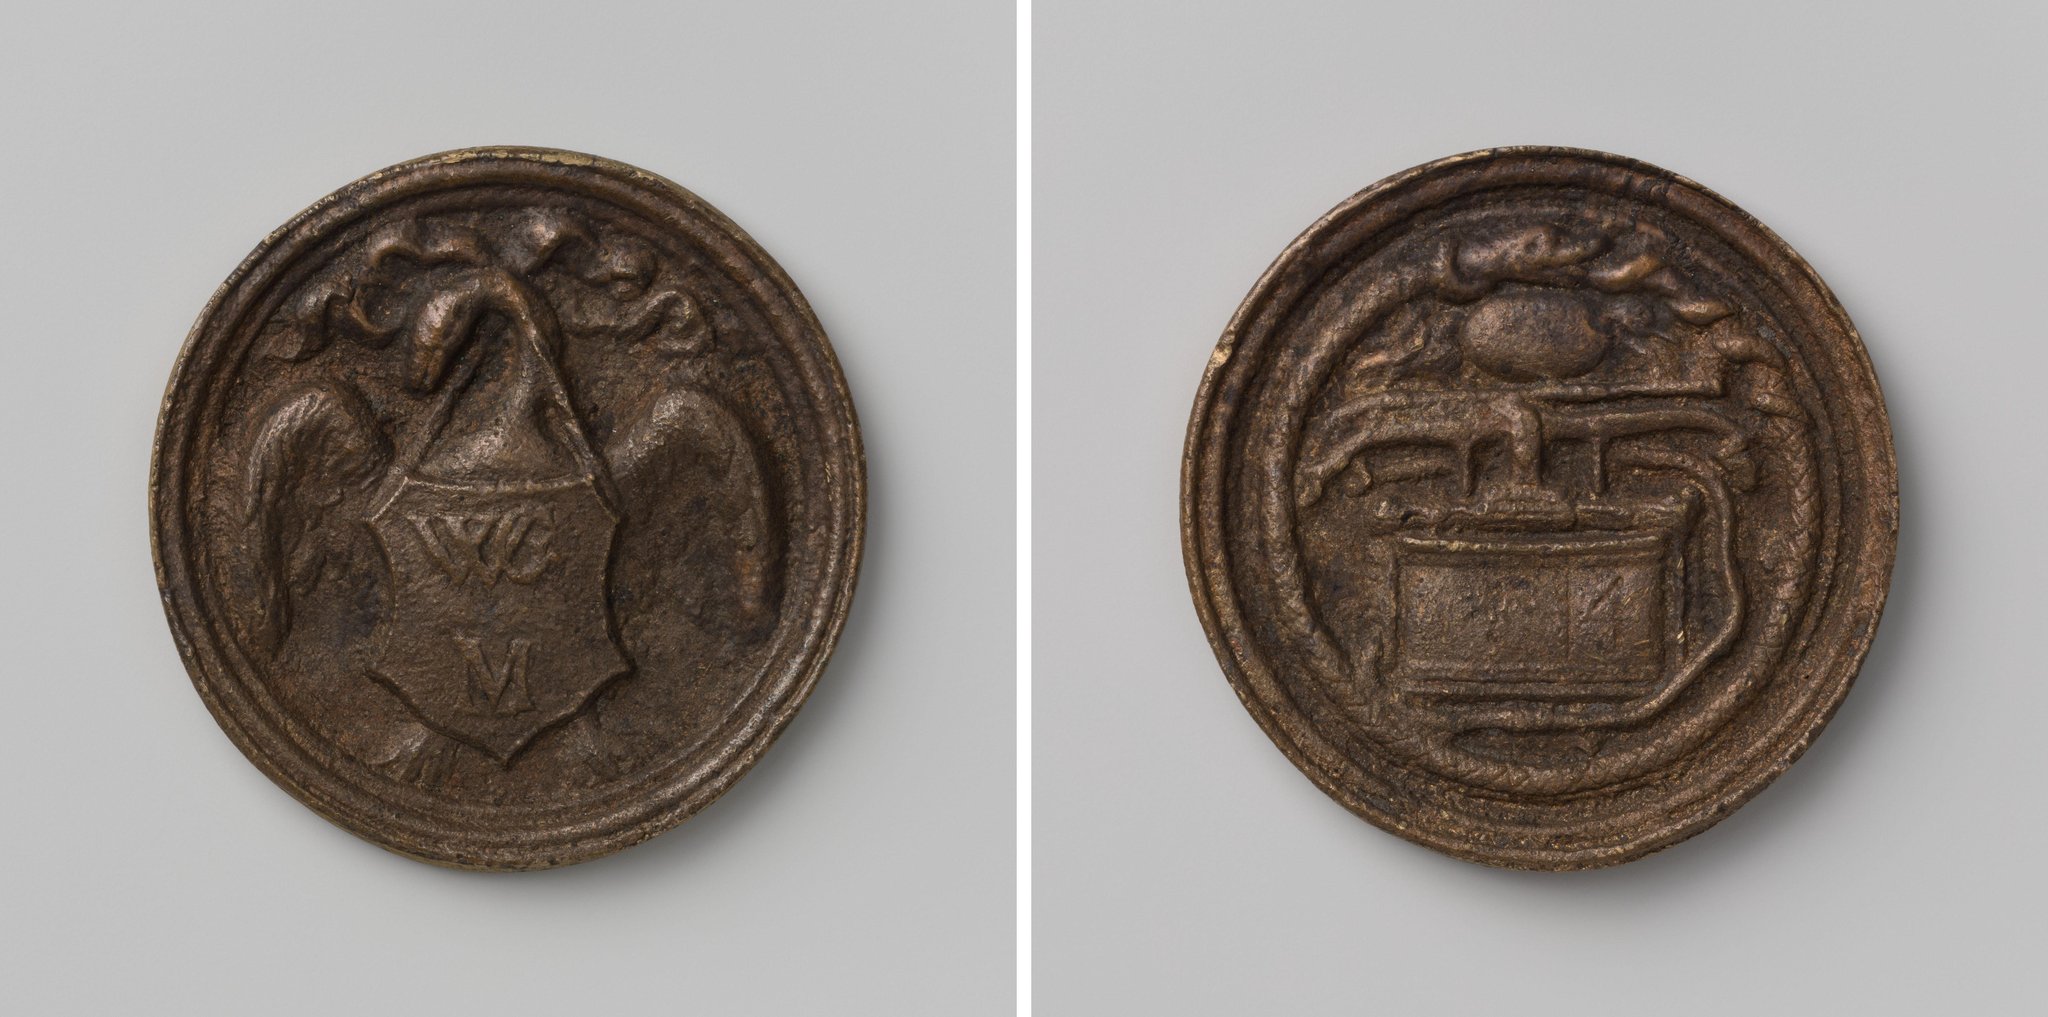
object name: fire engine medal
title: Watergraafsmeer, brandspuitpenning met no. 14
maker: Anonymous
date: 1680-1800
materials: brass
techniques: casting, engraving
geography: amsterdam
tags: watergraafsmeer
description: Messing penning. Voorzijde: zwaan met uitgespreide vleugels draagt wapenschild dat met lint om zijn nek hangt. Keerzijde: brandspuit onder leeg cartouche binnen slangerond; op zijde van brandspuit: cijfer 14